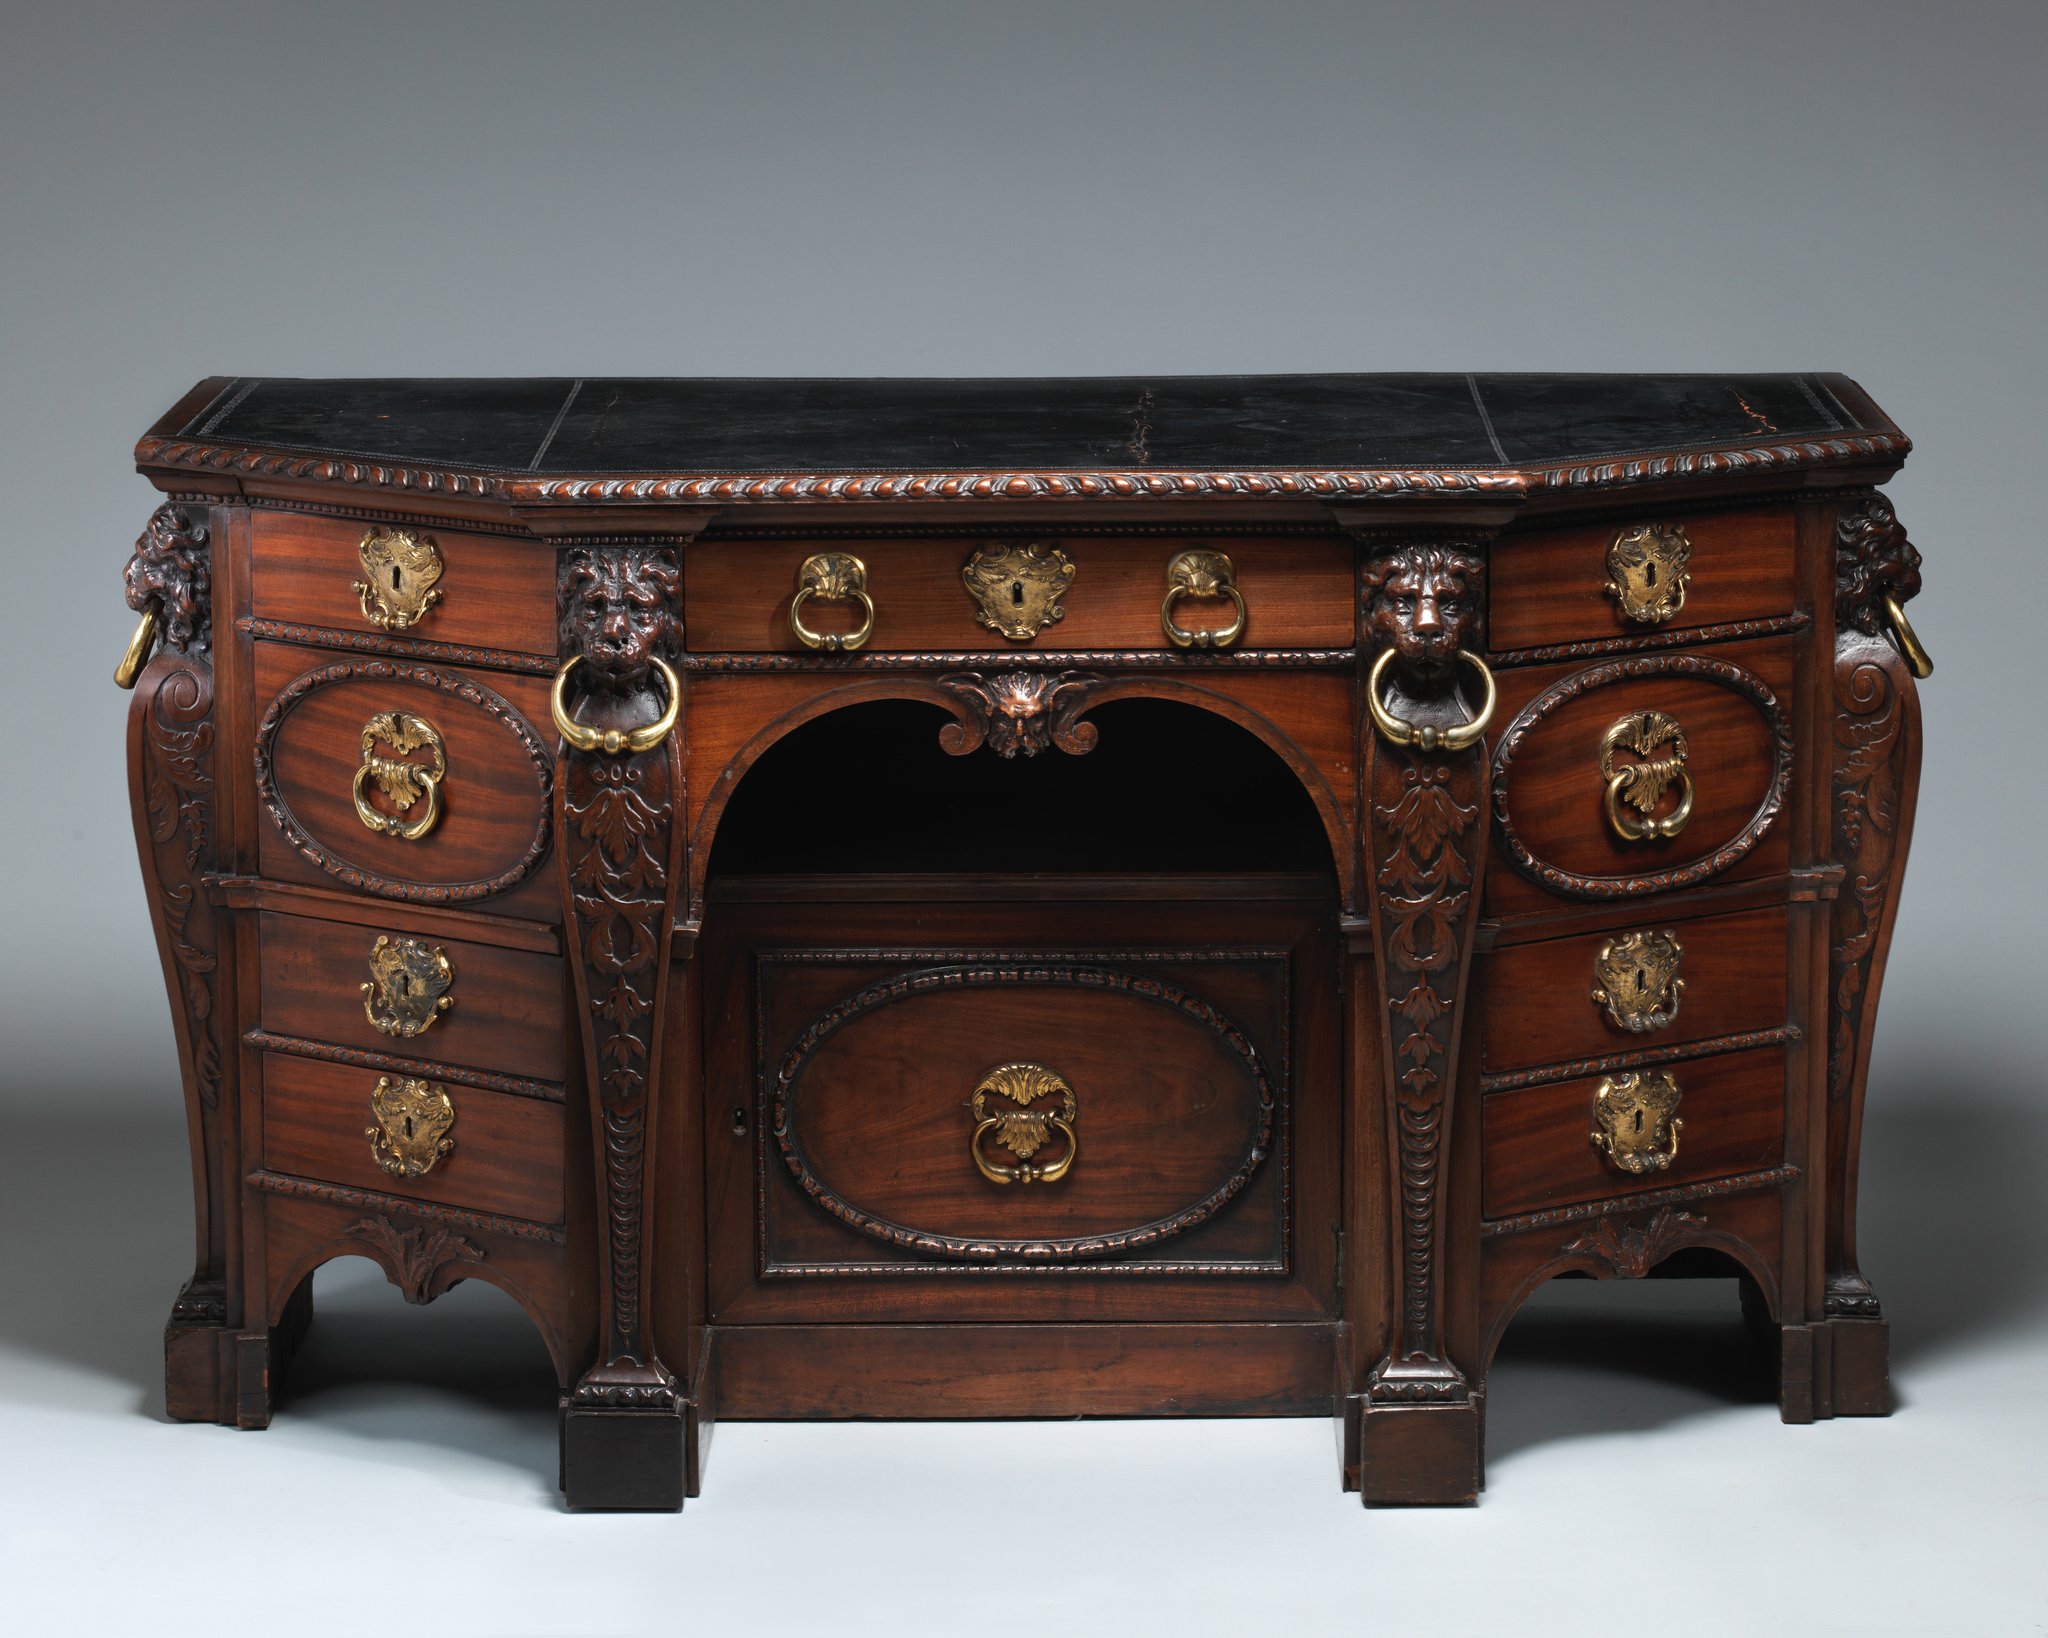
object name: library table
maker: william kent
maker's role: artist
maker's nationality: british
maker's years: 1685-1748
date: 1735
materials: brass, gilt, wood